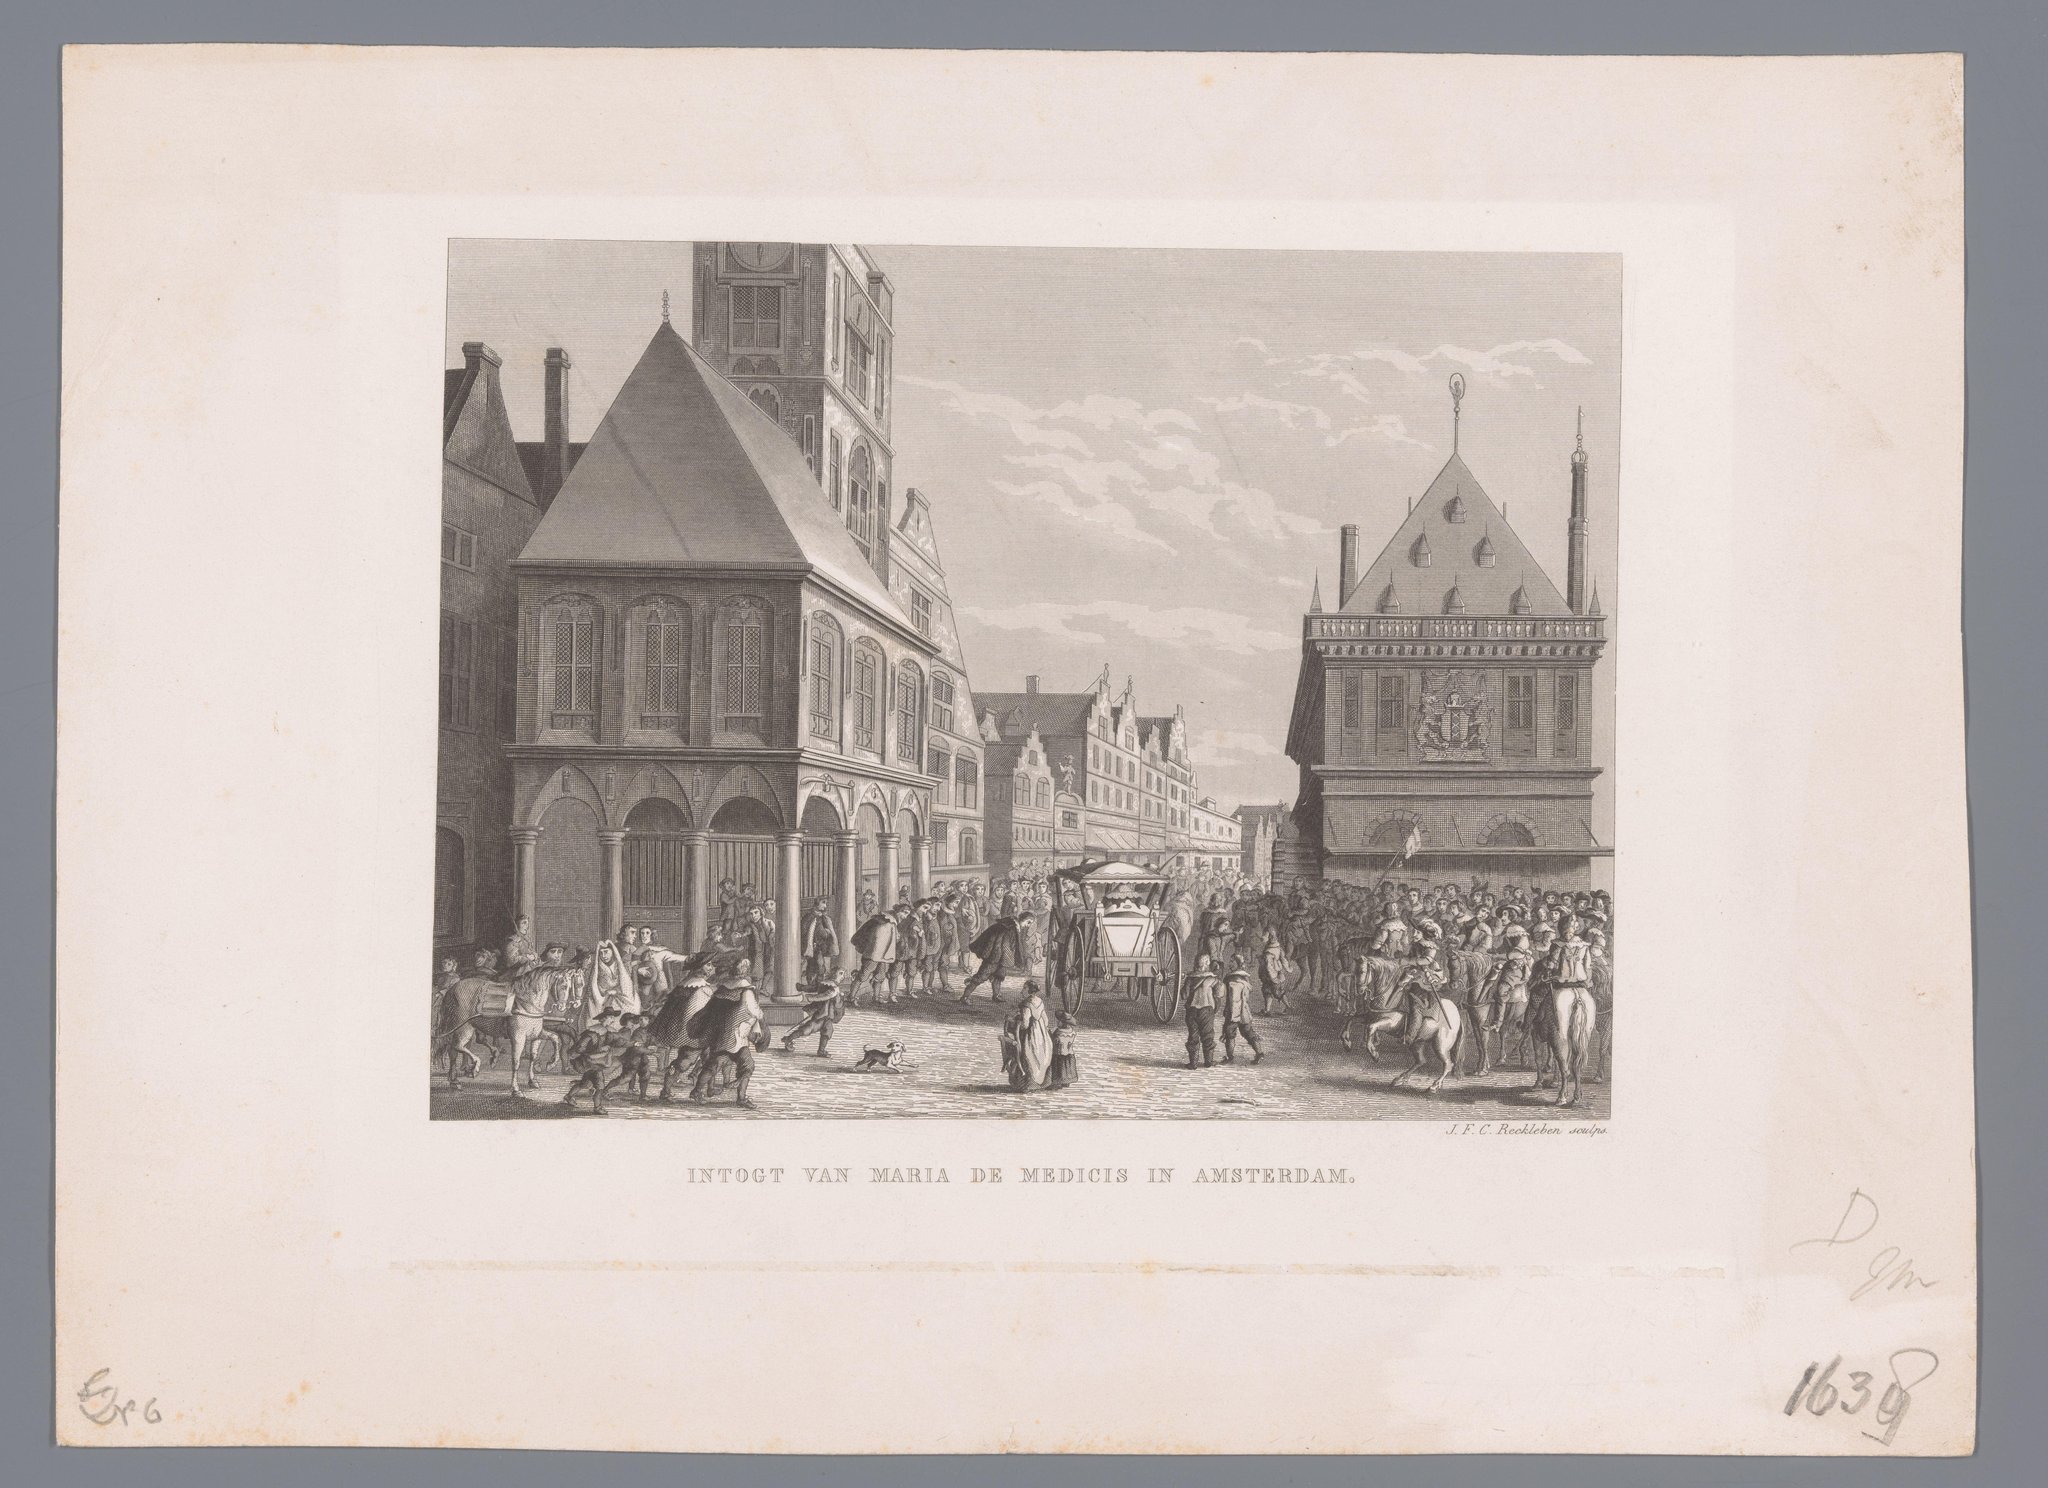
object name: print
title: Intogt van Maria de Medicis in Amsterdam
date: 1874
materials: paper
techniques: engraving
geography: amsterdam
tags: print maker, maria de' medici, crowd, mob, mayor, burgomaster, homage to a ruler, waving farewell ~ departure on a journey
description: Het vertrek van de koningin op 5 september 1638. De vier Amsterdamse burgemeesters nemen afscheid van Maria de' Medici op de Dam tussen het oude stadhuis en de Waag. Afsluiting van de feestelijkheden bij het bezoek van Maria de' Medici aan Amsterdam, 31 augustus - 5 september 1638.